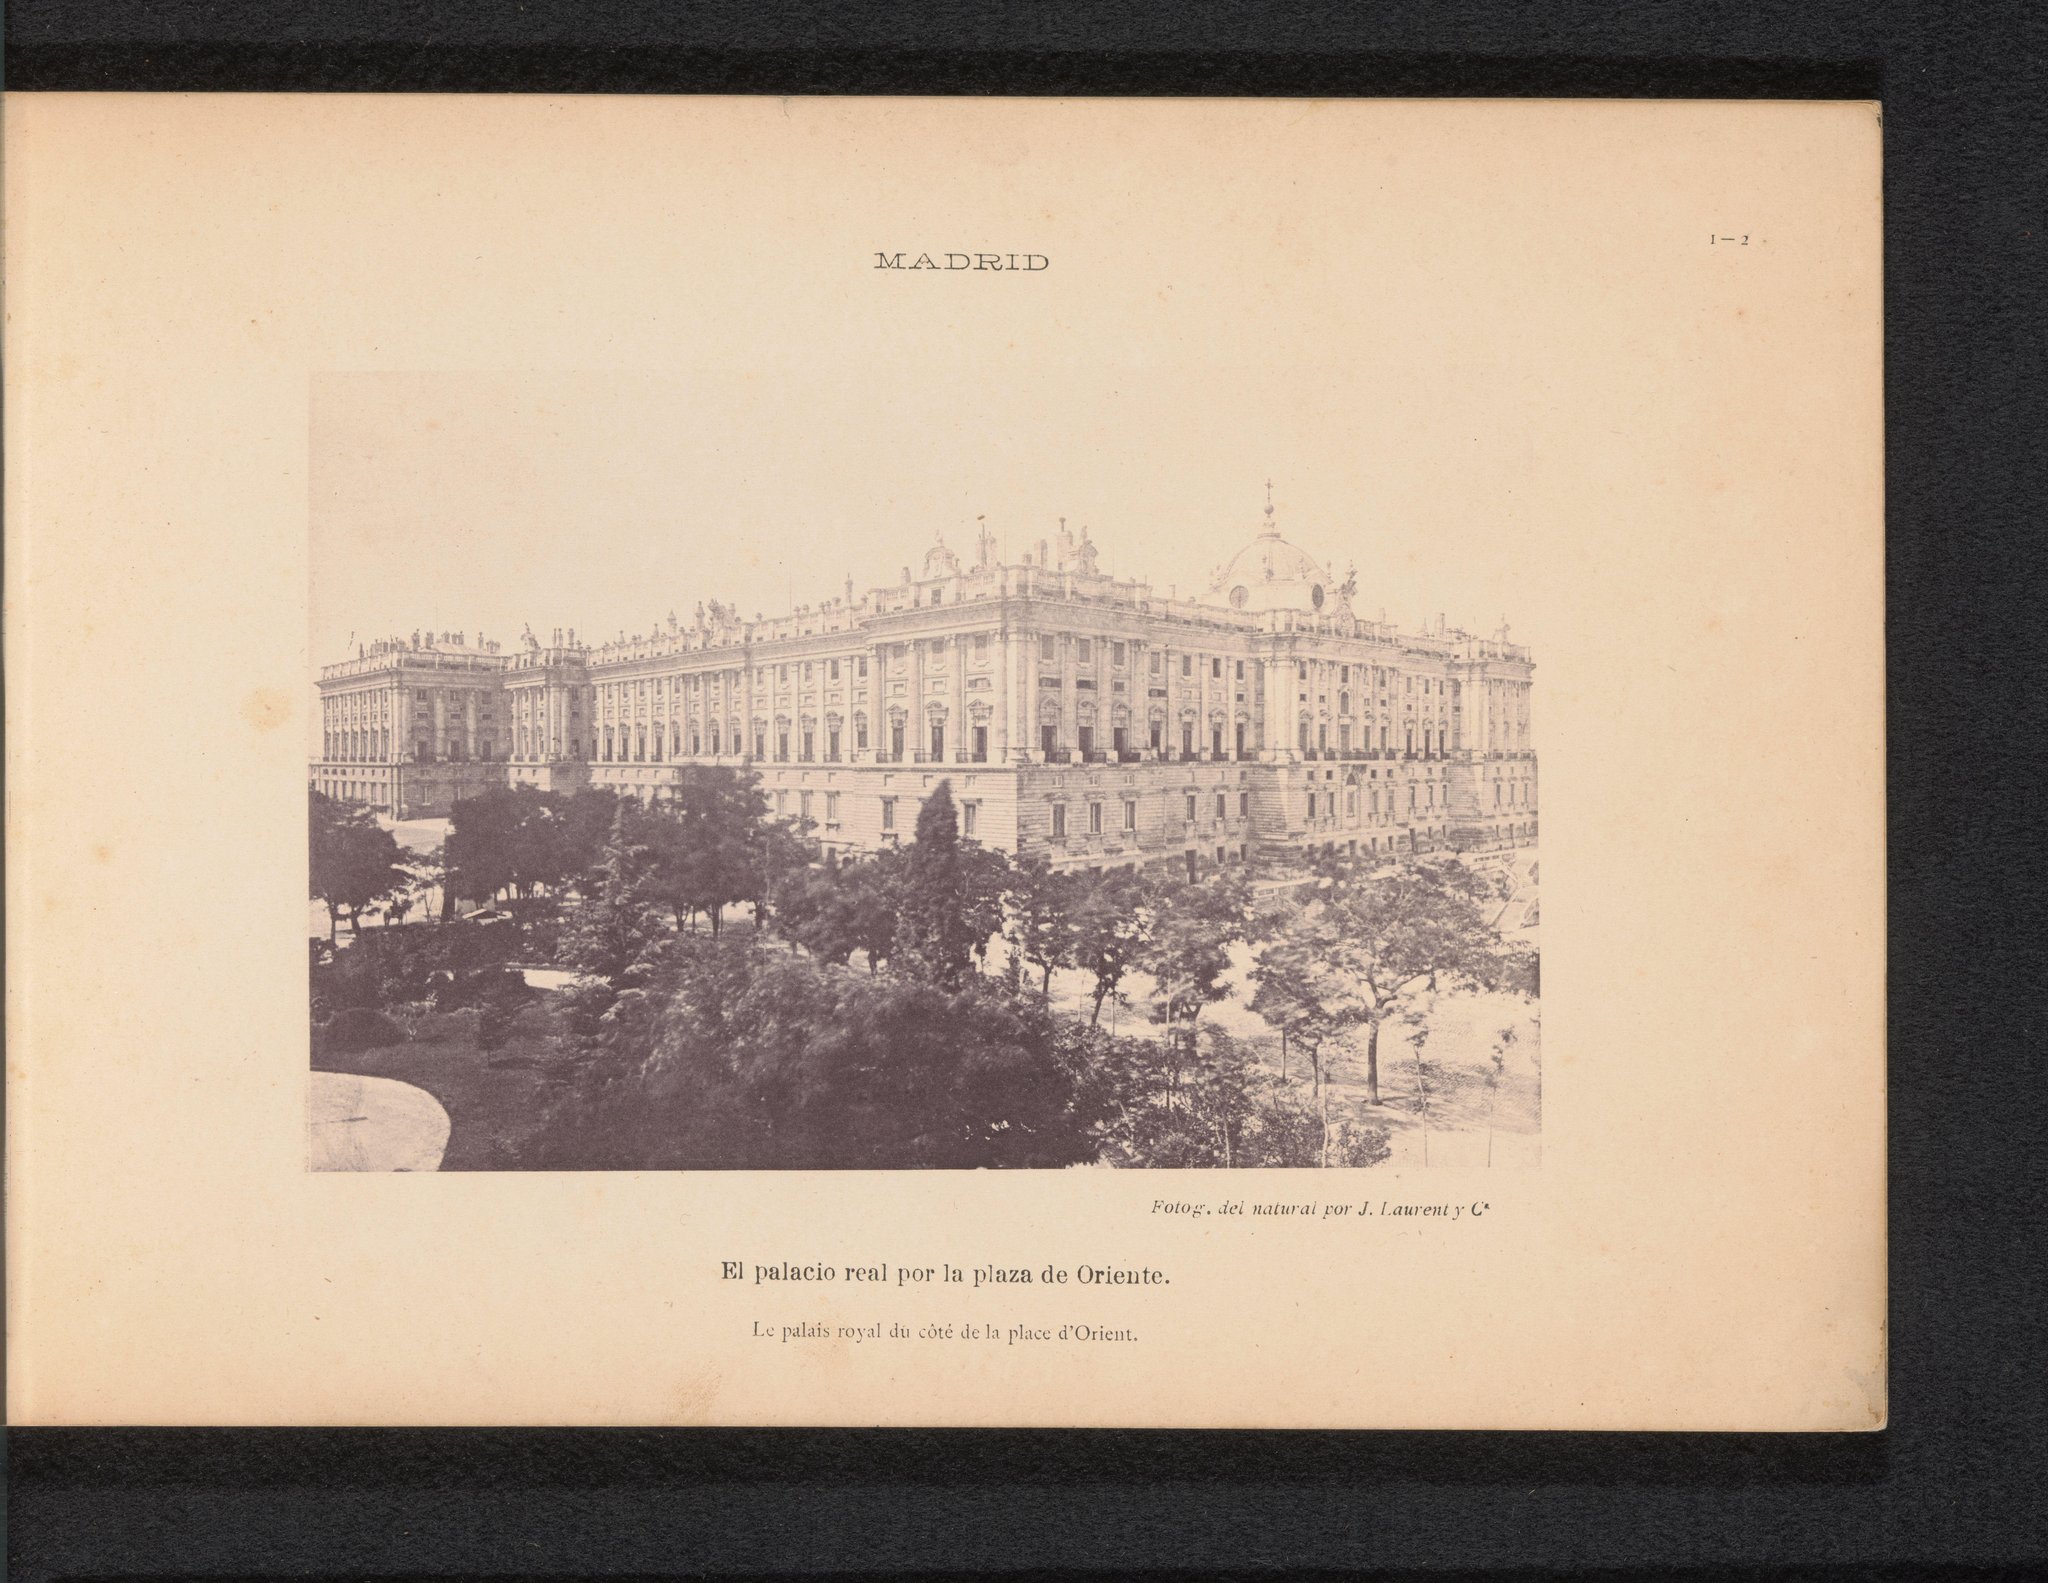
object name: photomechanical print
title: El palacio real por la plaza de Oriente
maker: juan laurent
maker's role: publisher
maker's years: 1816-1896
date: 1880-1890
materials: paper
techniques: photograph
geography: plaza de oriente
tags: palace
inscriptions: number: ‘1-2’